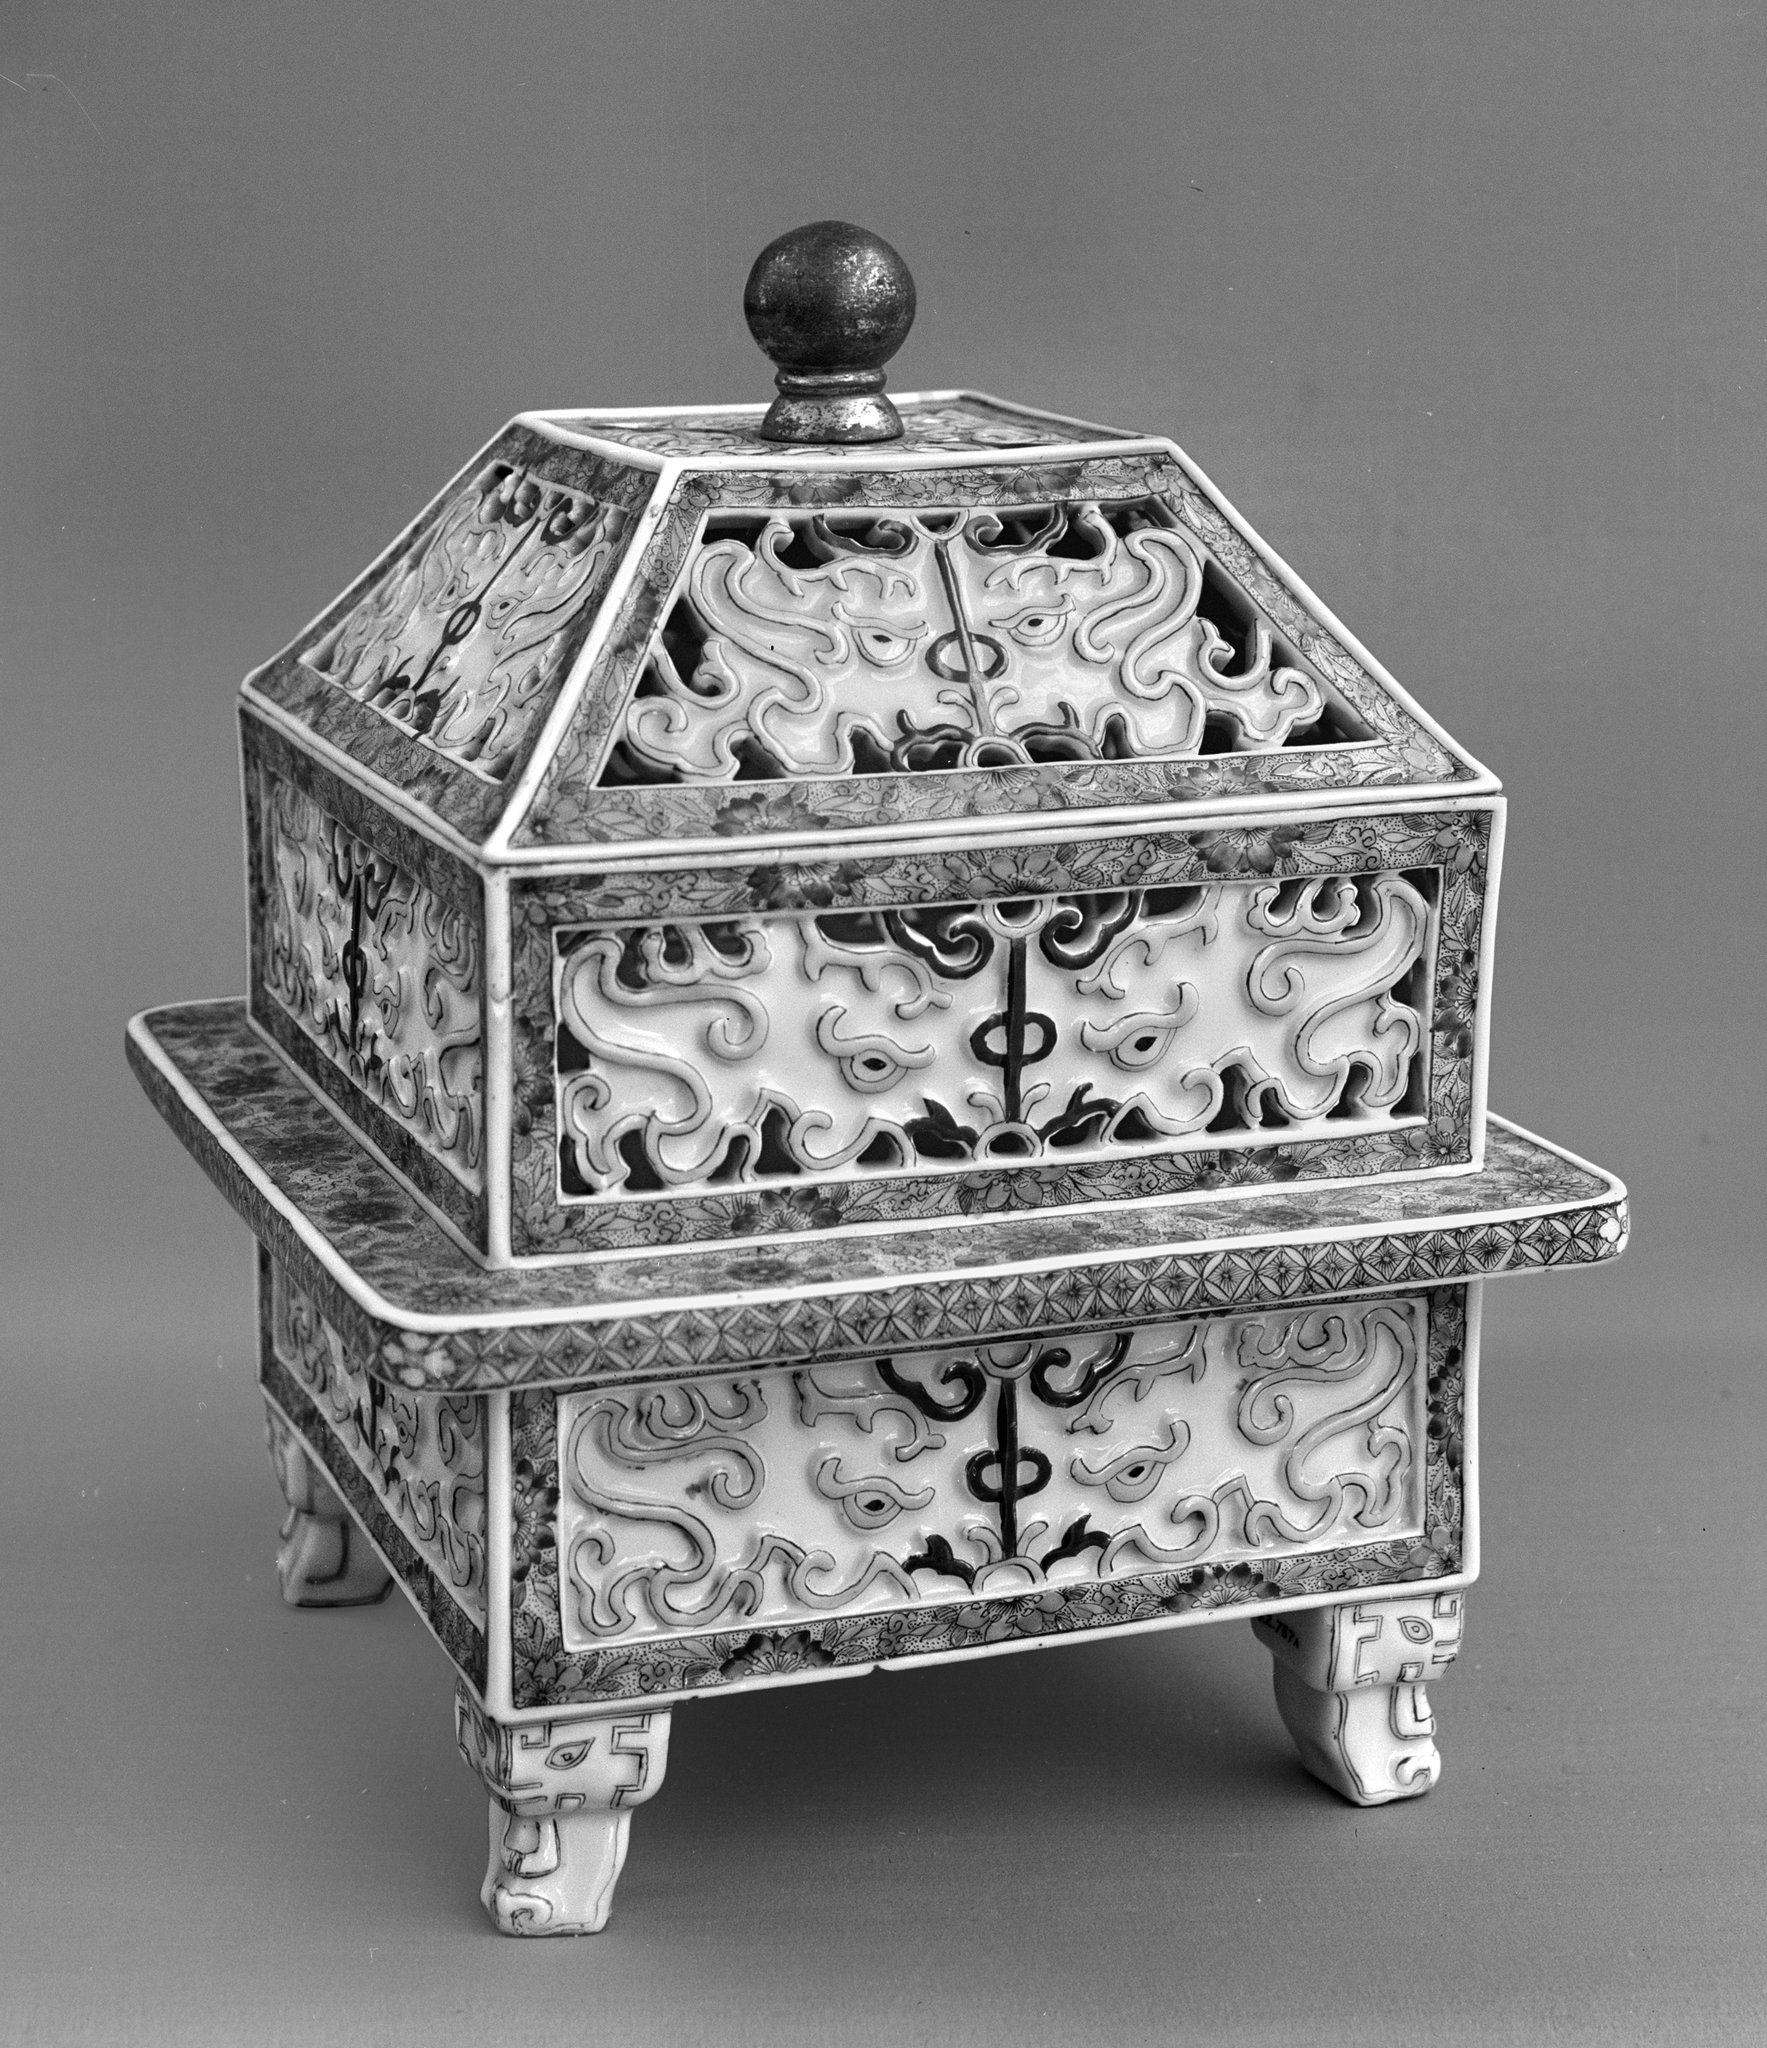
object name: incense burner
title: Incenser burner with archaic style patterns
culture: chinese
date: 1667-1733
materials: enamel, porcelain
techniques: overglaze, painting, polychrome